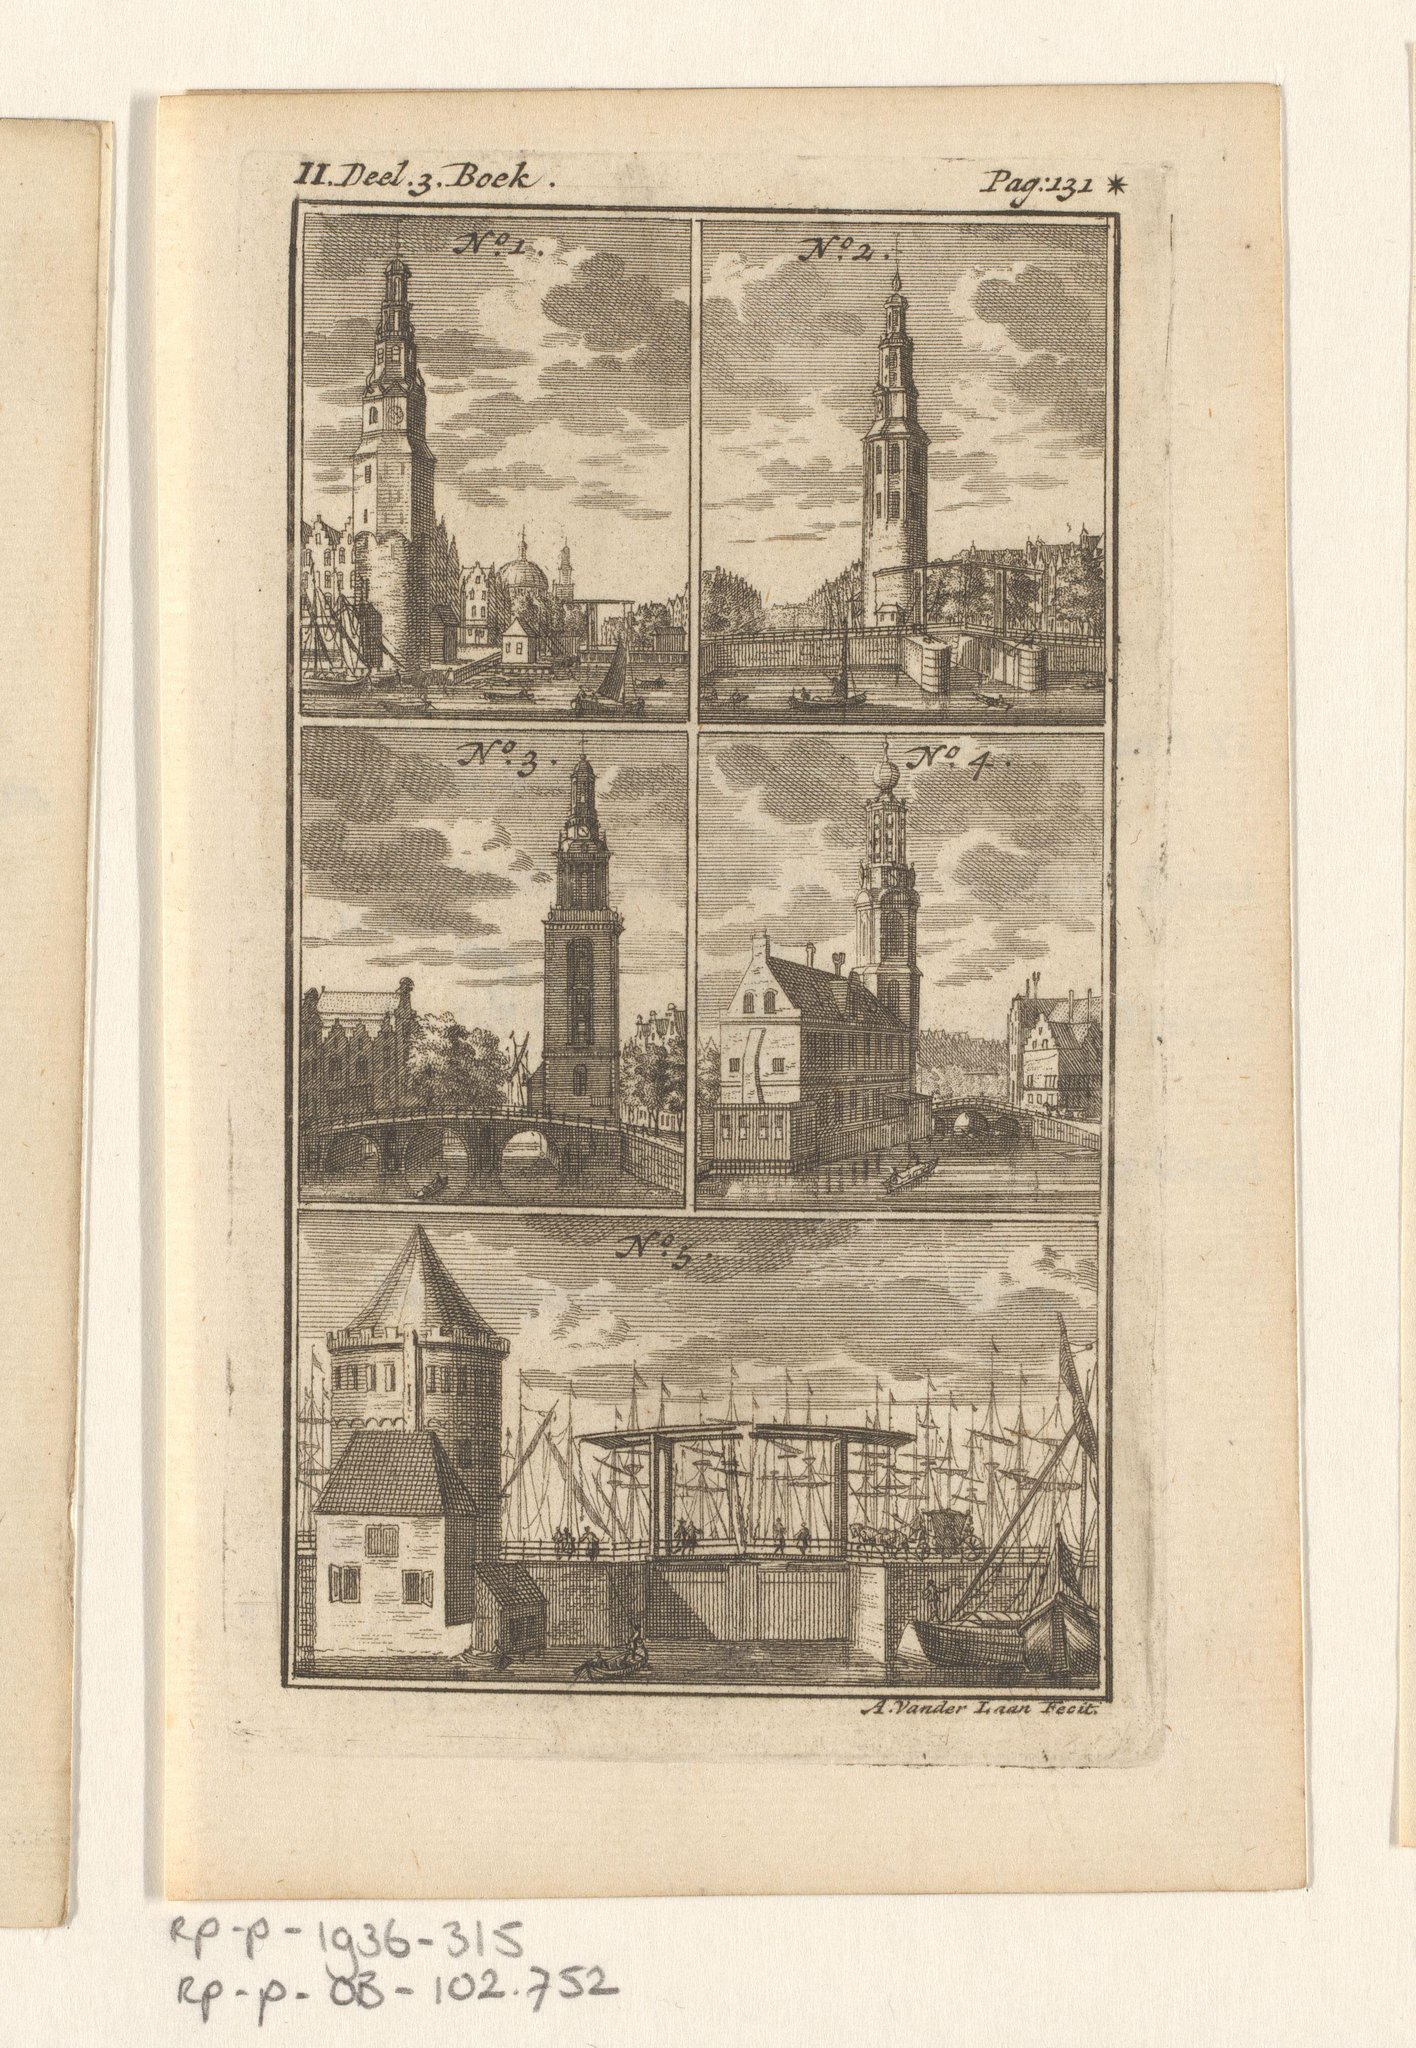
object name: text sheet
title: Tekstblad bij boekillustratie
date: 1723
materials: paper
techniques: letterpress printing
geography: amsterdam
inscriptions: collector's mark: Lugt 2760, collector's mark: Lugt 2228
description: Tekstblad uit: Leuve, Roeland van. 's Waerelds koopslot of De Amsteldamse beurs. Amsterdam: Jacobus Verheyden (I), 1723.